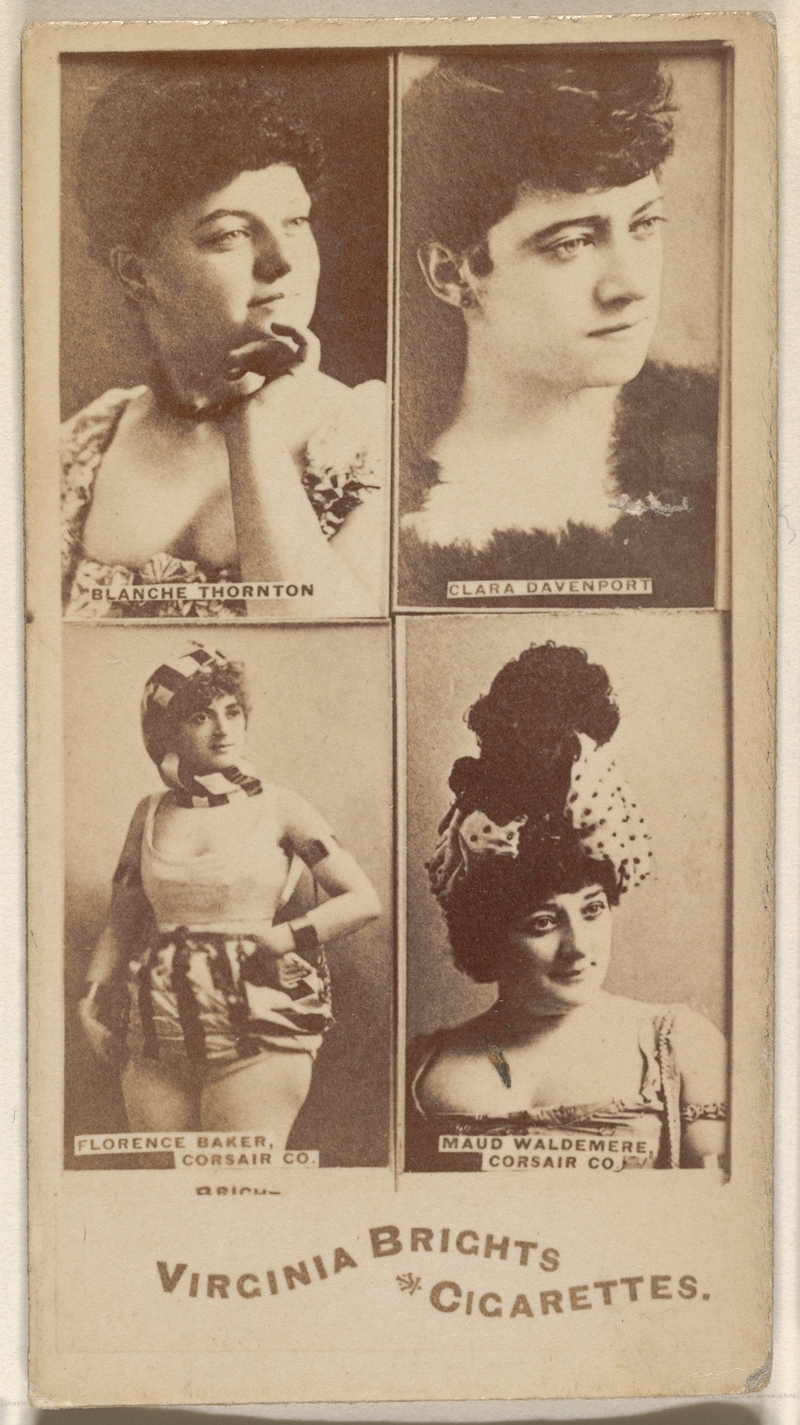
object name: photograph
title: Blanche Thornton/ Clara Davenport/ Florence Baker, Corsair Co./ Maud Waldemere, Corsair Co., from the Actors and Actresses series (N45, Type 4) for Virginia Brights Cigarettes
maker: allen & ginter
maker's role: publisher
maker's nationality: american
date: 1888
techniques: albumen silver print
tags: portraits,women,actresses